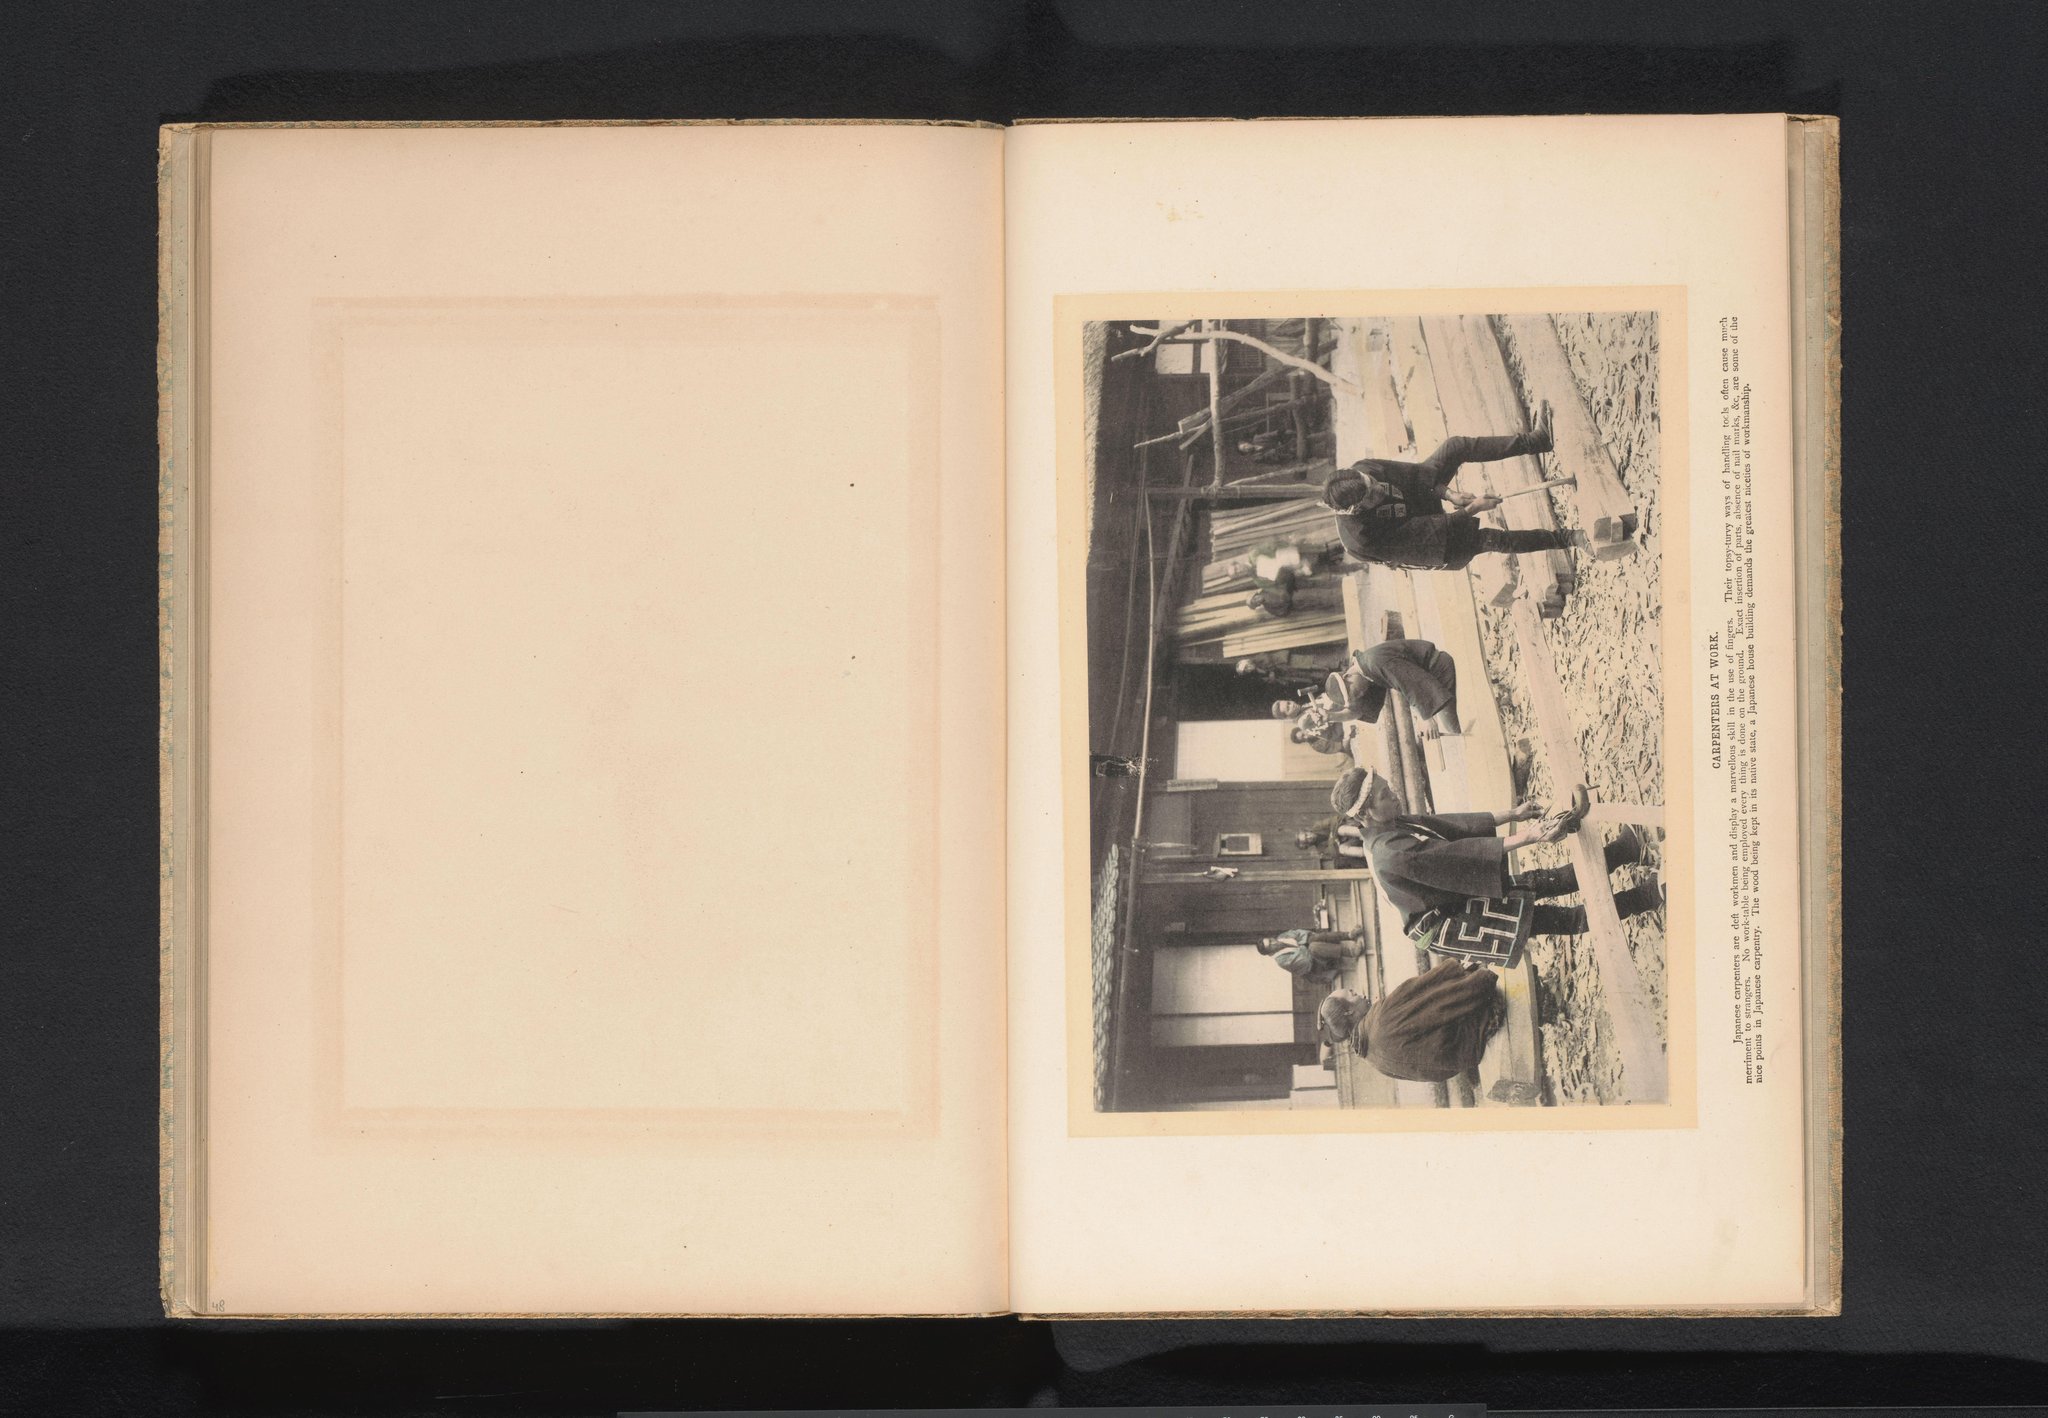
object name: page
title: Carpenters at Work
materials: paper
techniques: photograph, lithograph, hand coloring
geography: japan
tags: carpenter (+ men (labourers)), japan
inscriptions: inscription: ‘Japanese carpenters (...) of workmanship.’